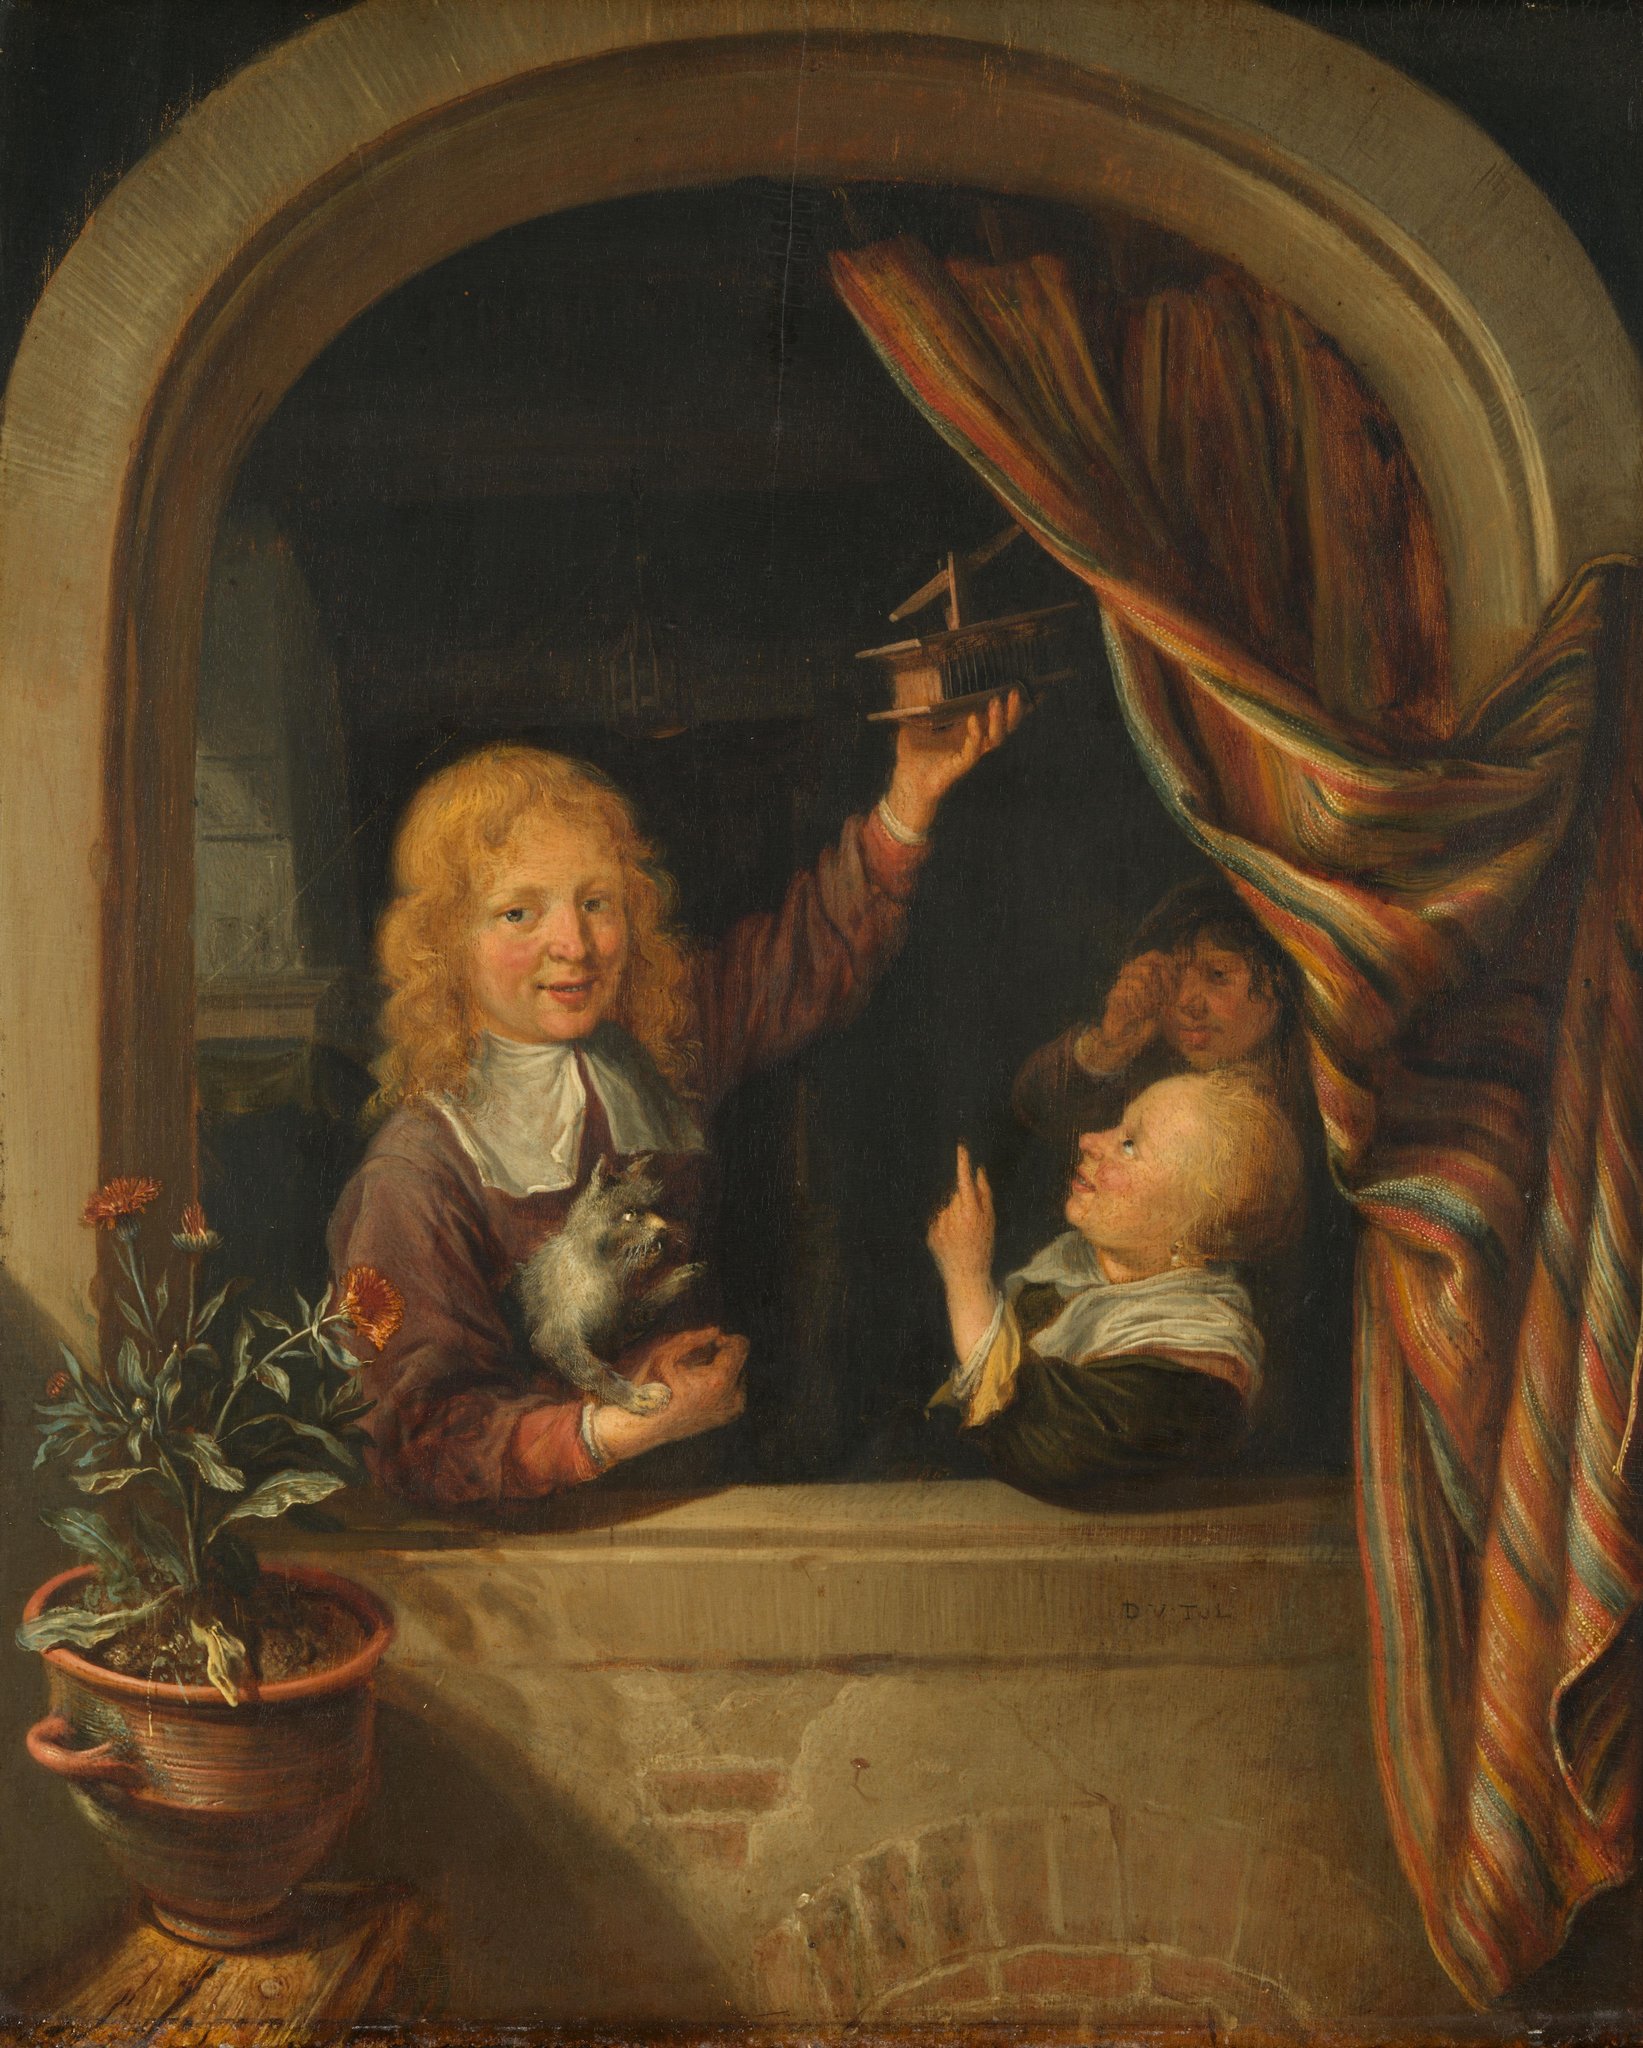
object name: painting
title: Children with a mousetrap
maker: domenicus van tol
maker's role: painter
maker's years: 1625-1676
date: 1660-1676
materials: oil, panel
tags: cat, child, human figure at (open) window, seen from outside, mouse trap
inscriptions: signature: ‘D. V. Tol’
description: Kinderen met een muizenval. In een stenen venster met gordijn houdt een jongetje in zijn linkerhand een muizenval omhoog, met zijn rechterarm houdt hij een kat vast. Naast hem een meisje die naar de val wijst, achter haar een huilende jongen. Voor het venster een plant in een pot.